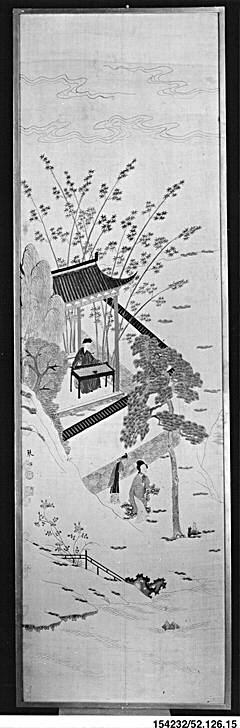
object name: screen panel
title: Screen Panel from Set of Six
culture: chinese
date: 1767-1833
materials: silk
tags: human figures,houses